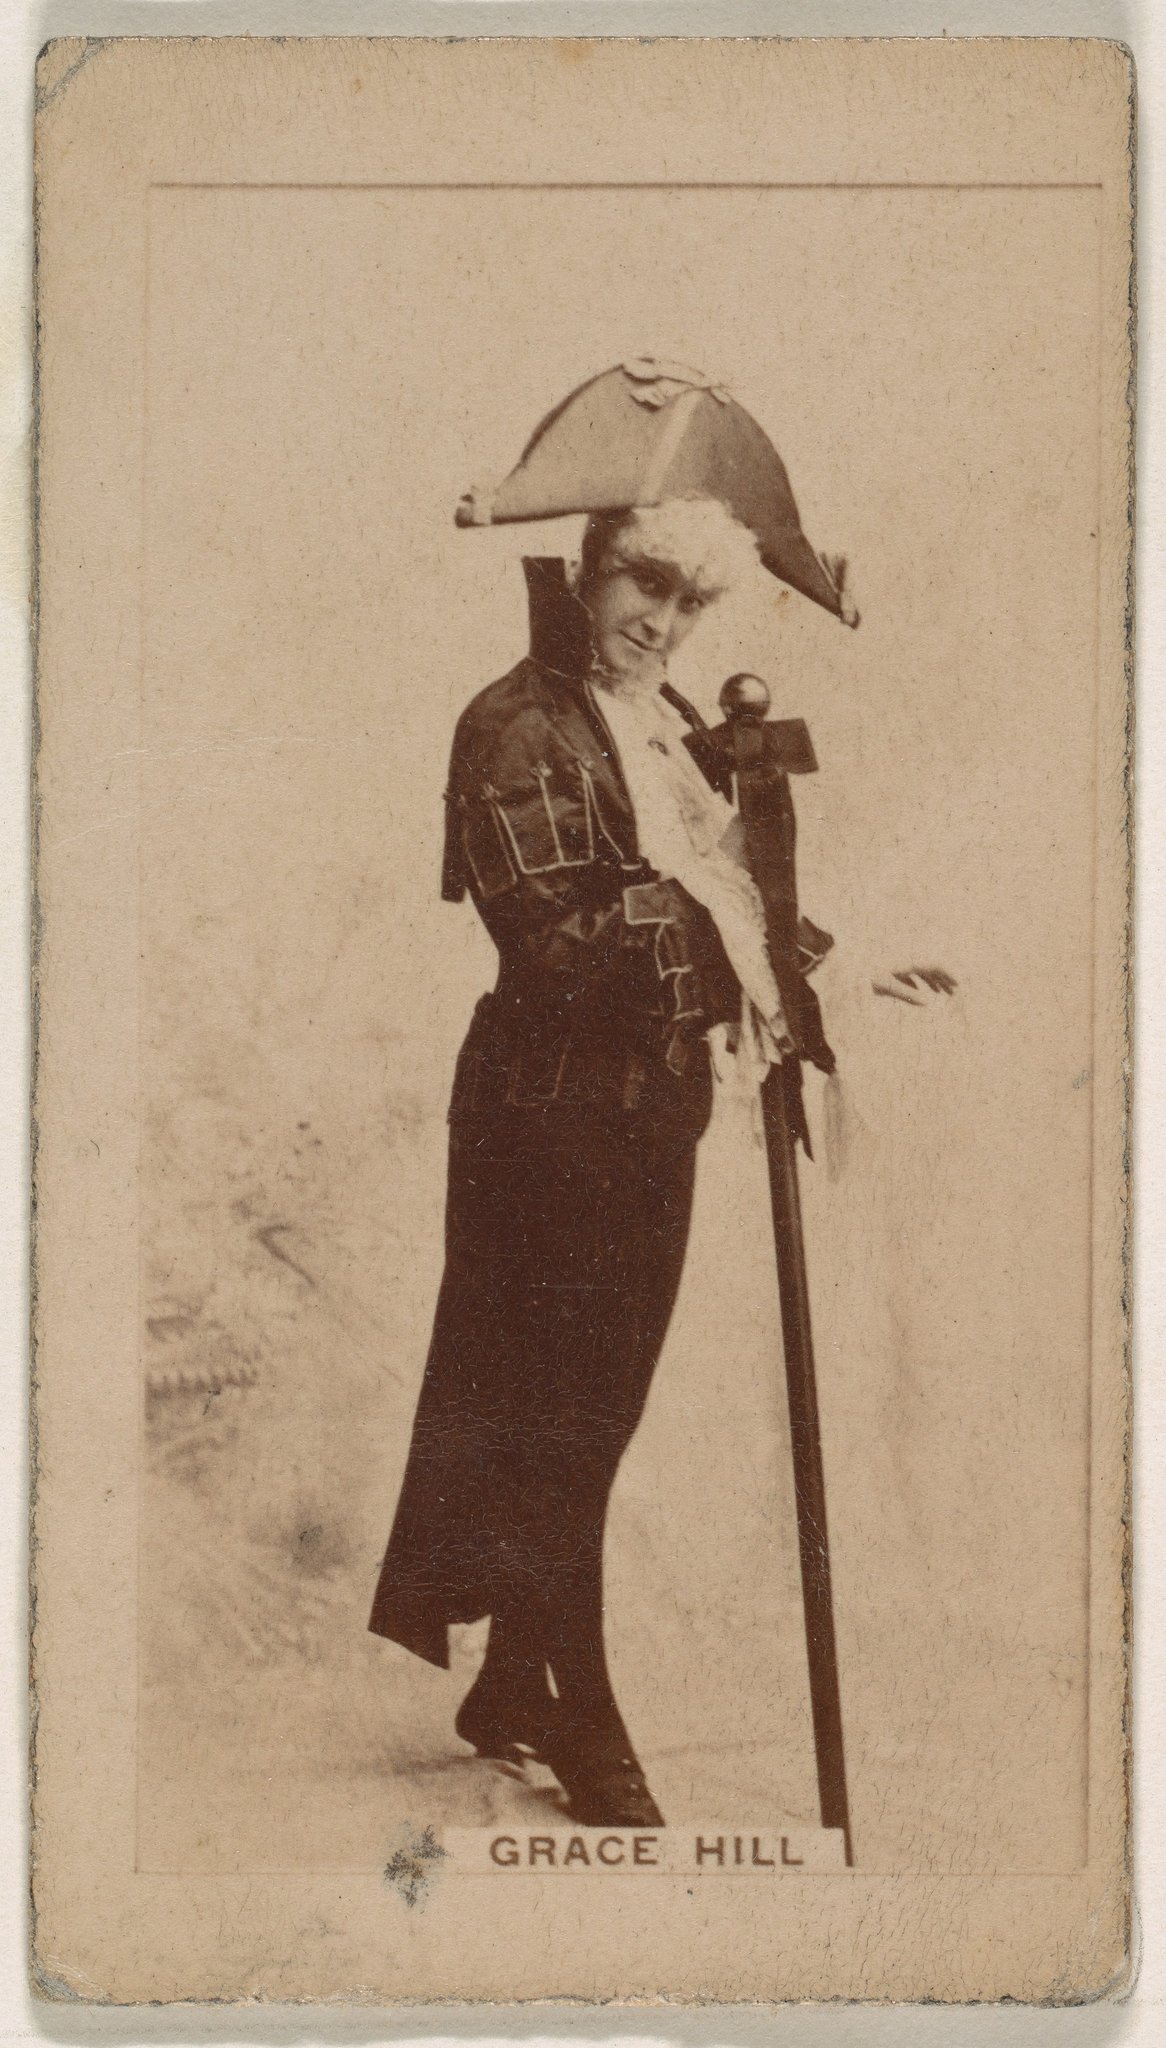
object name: photograph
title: Grace Hill, from the Actresses series (N245) issued by Kinney Brothers to promote Sweet Caporal Cigarettes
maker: kinney brothers tobacco company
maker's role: publisher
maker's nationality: american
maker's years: 1869-2011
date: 1890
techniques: albumen silver print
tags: portraits,women,actresses